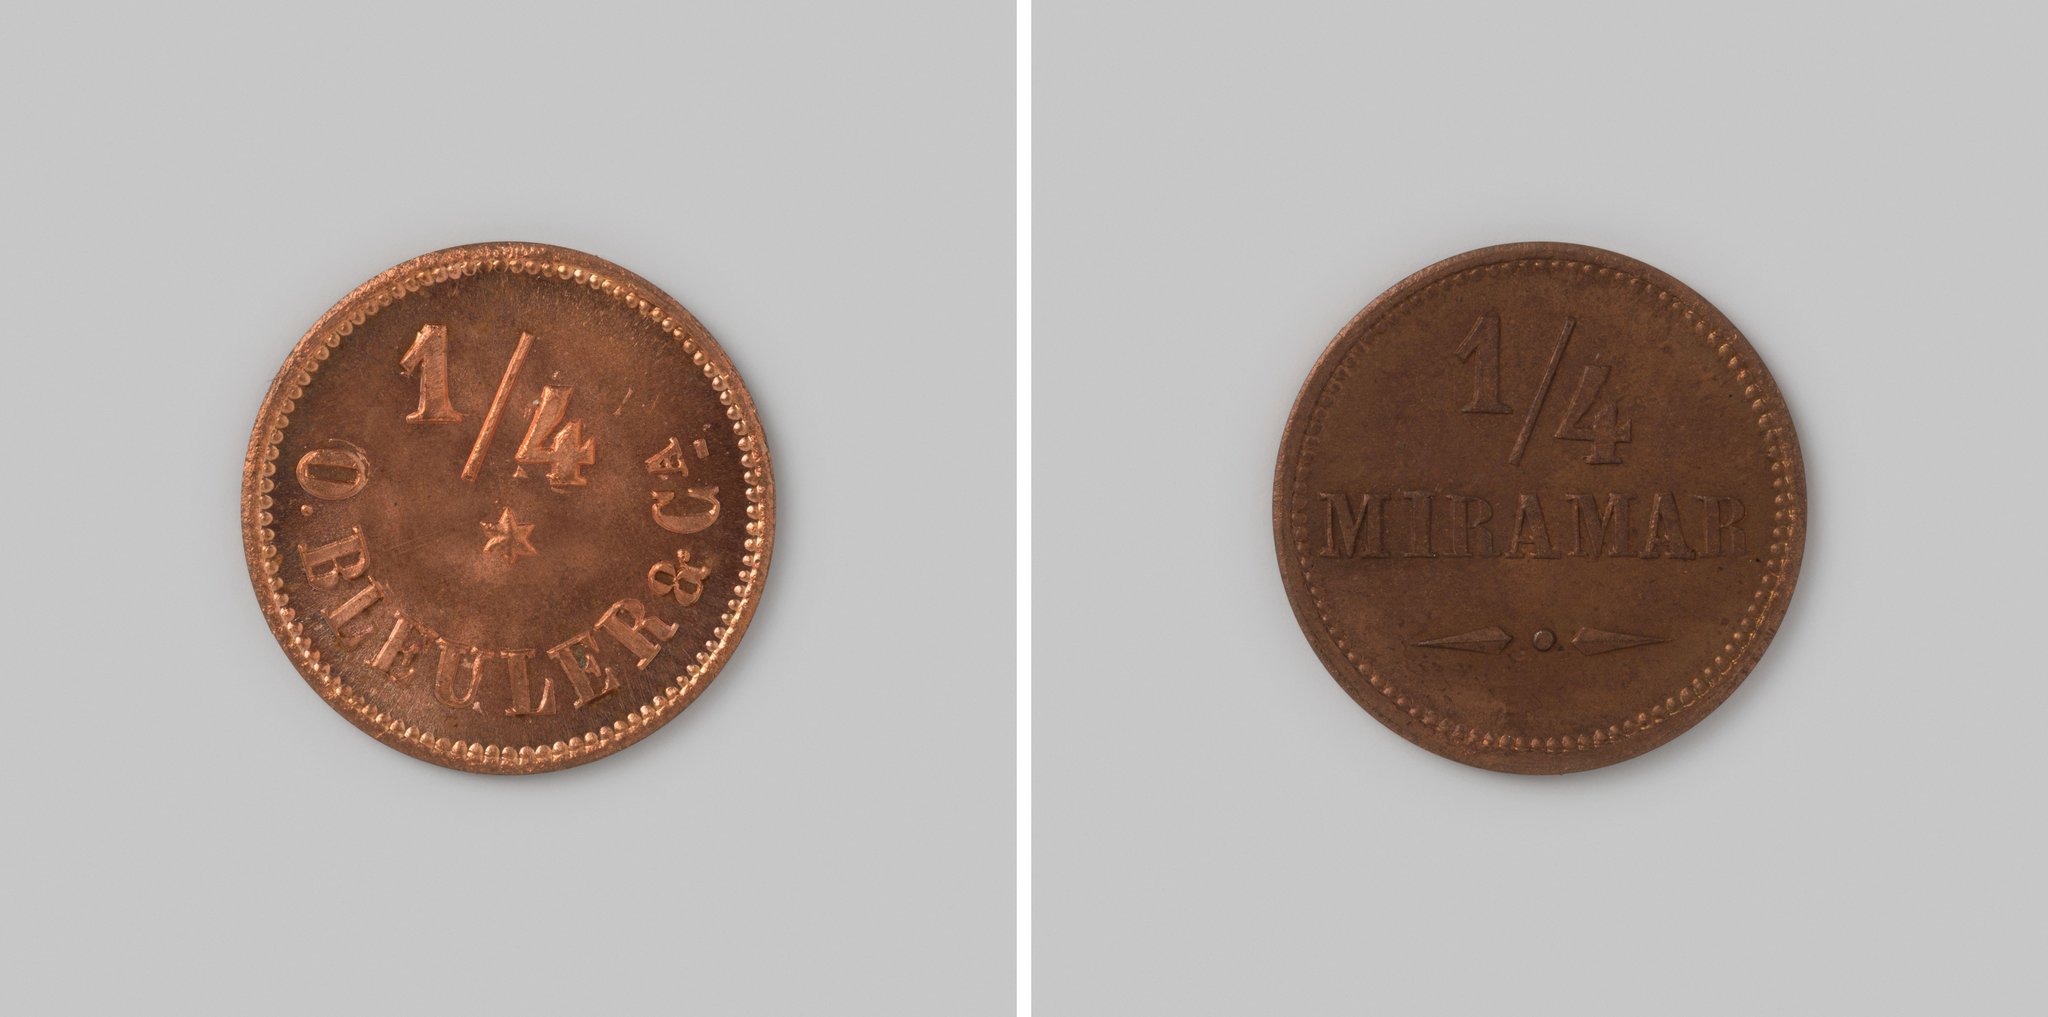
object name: kwart reaal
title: Particuliere munt van 1/4 reaal op naam van O. Bleuler & Co uit Miramar in Guatemala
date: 1800-1900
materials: copper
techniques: striking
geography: guatemala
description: Koperen particuliere munt. Voorzijde: waarde-aanduiding:1/4. In omschrift firma-aanduiding. Keerzijde: waarde-aanduiding:1/4. In omschrift plaats-aanduiding. Gladde rand.